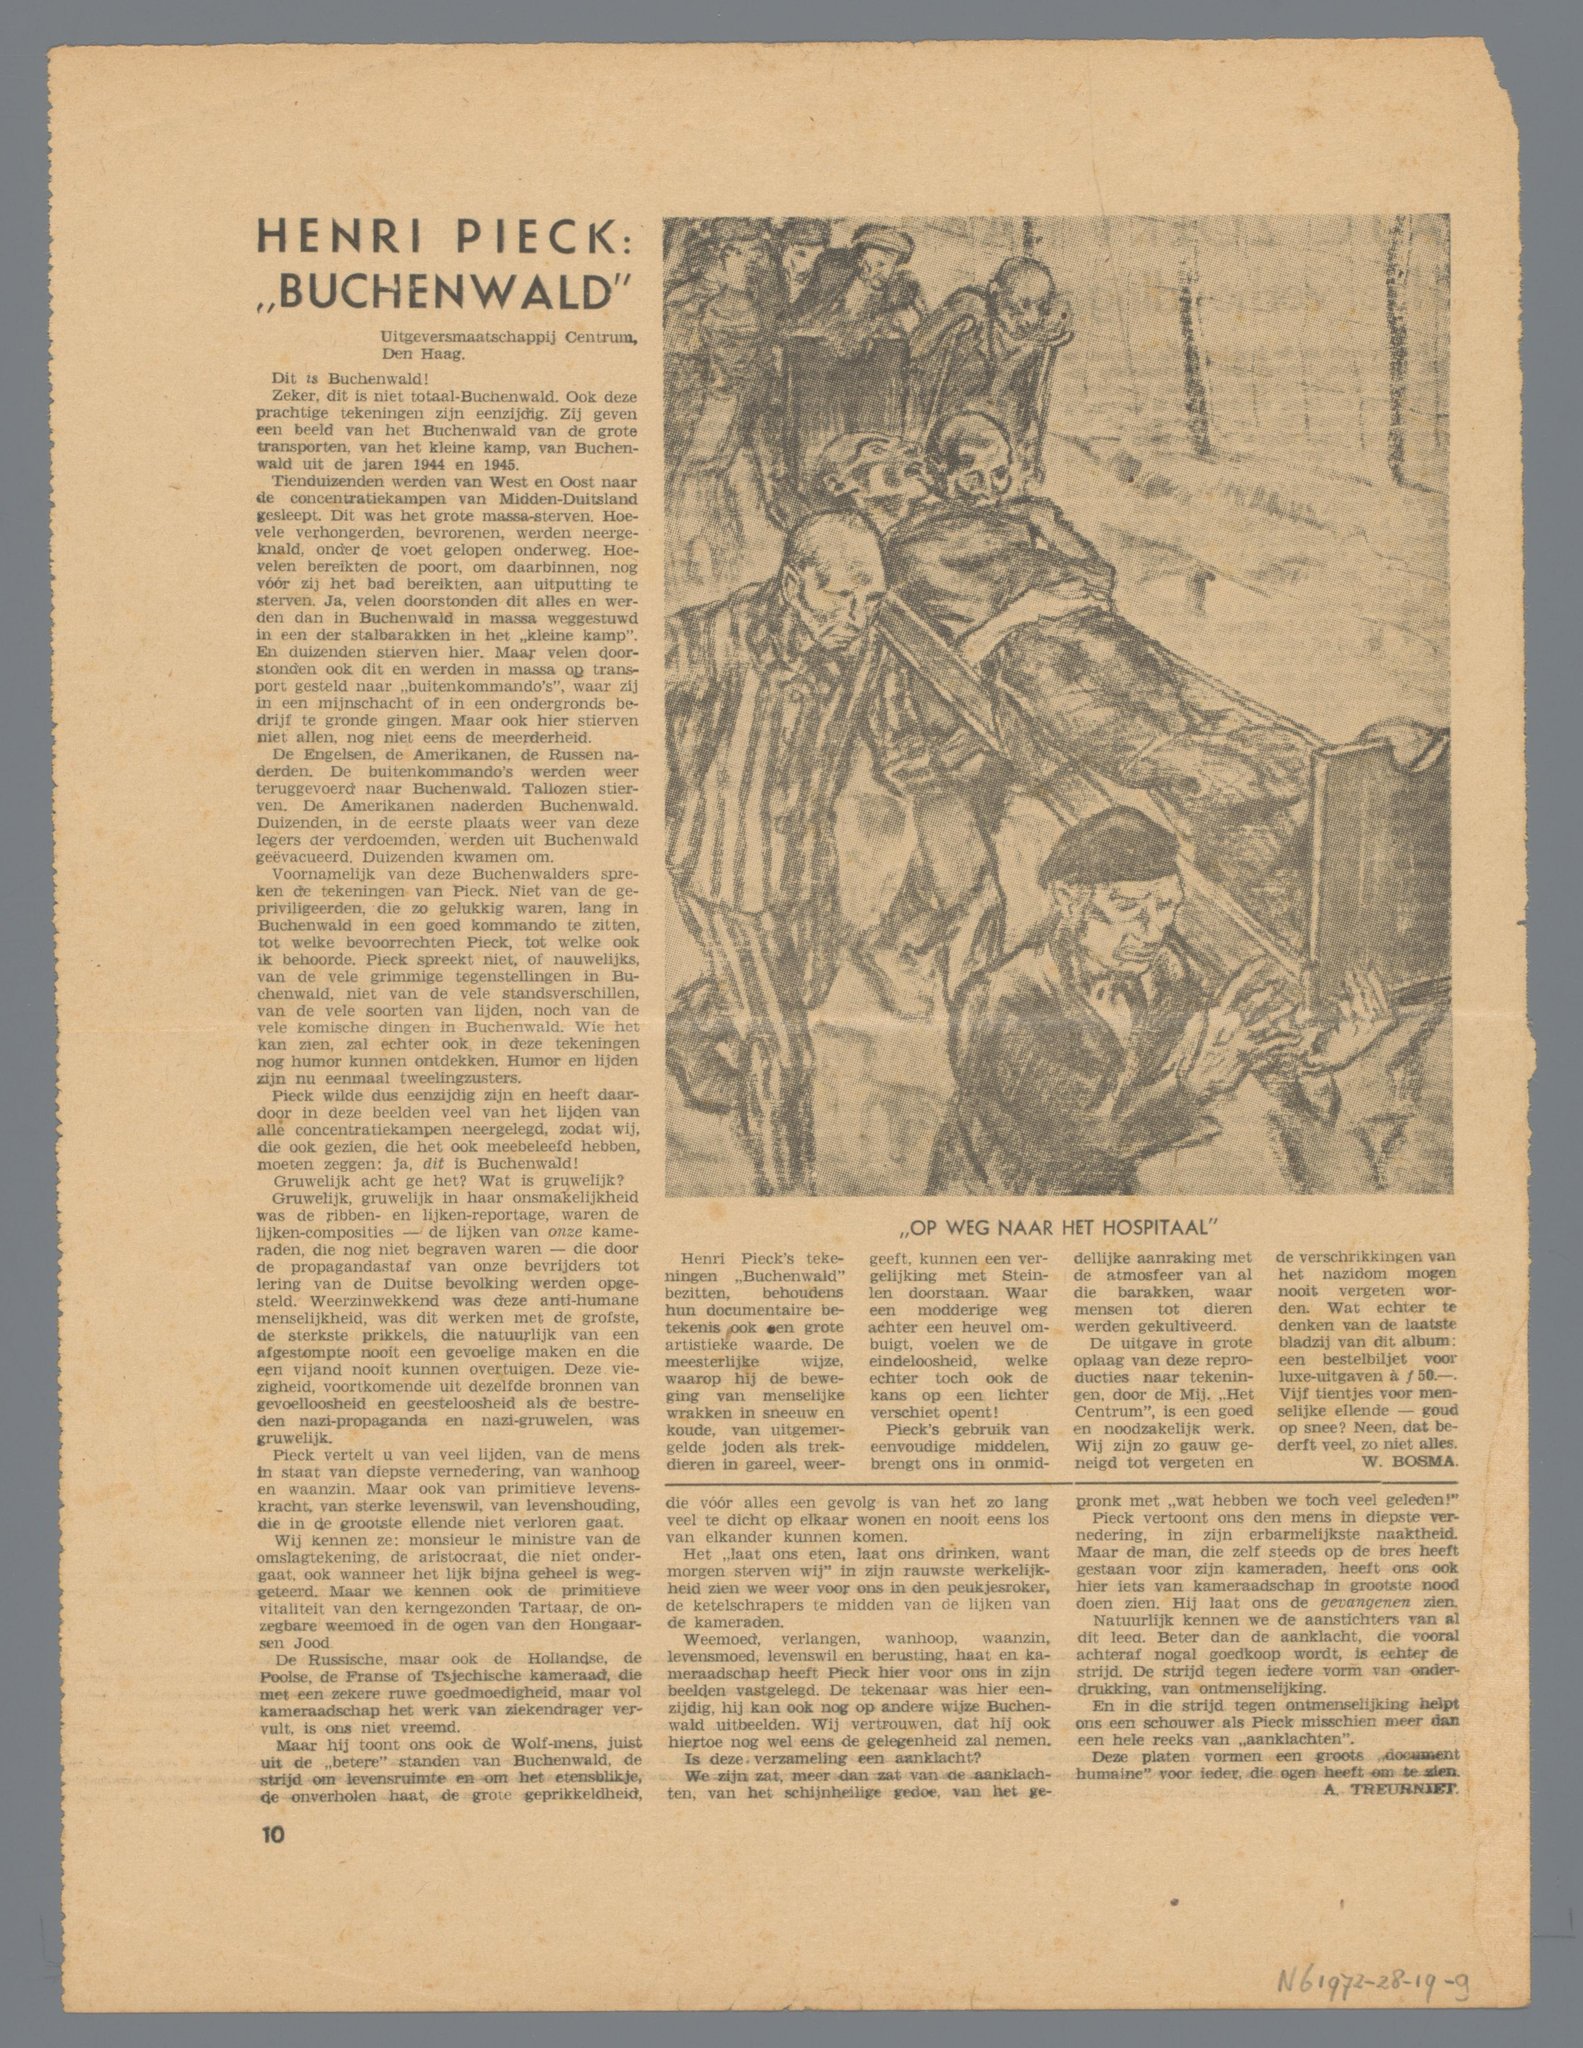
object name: newspaper clipping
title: Knipsel met artikel over Henri Piecks 'Buchenwald'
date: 1944-1945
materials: paper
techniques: printing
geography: netherlands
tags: concentration camp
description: Krantenknipsel uit 'De Vlam' met een artikel door W. Bosma over de uitgave van Henri Piecks 'Buchenwald'.